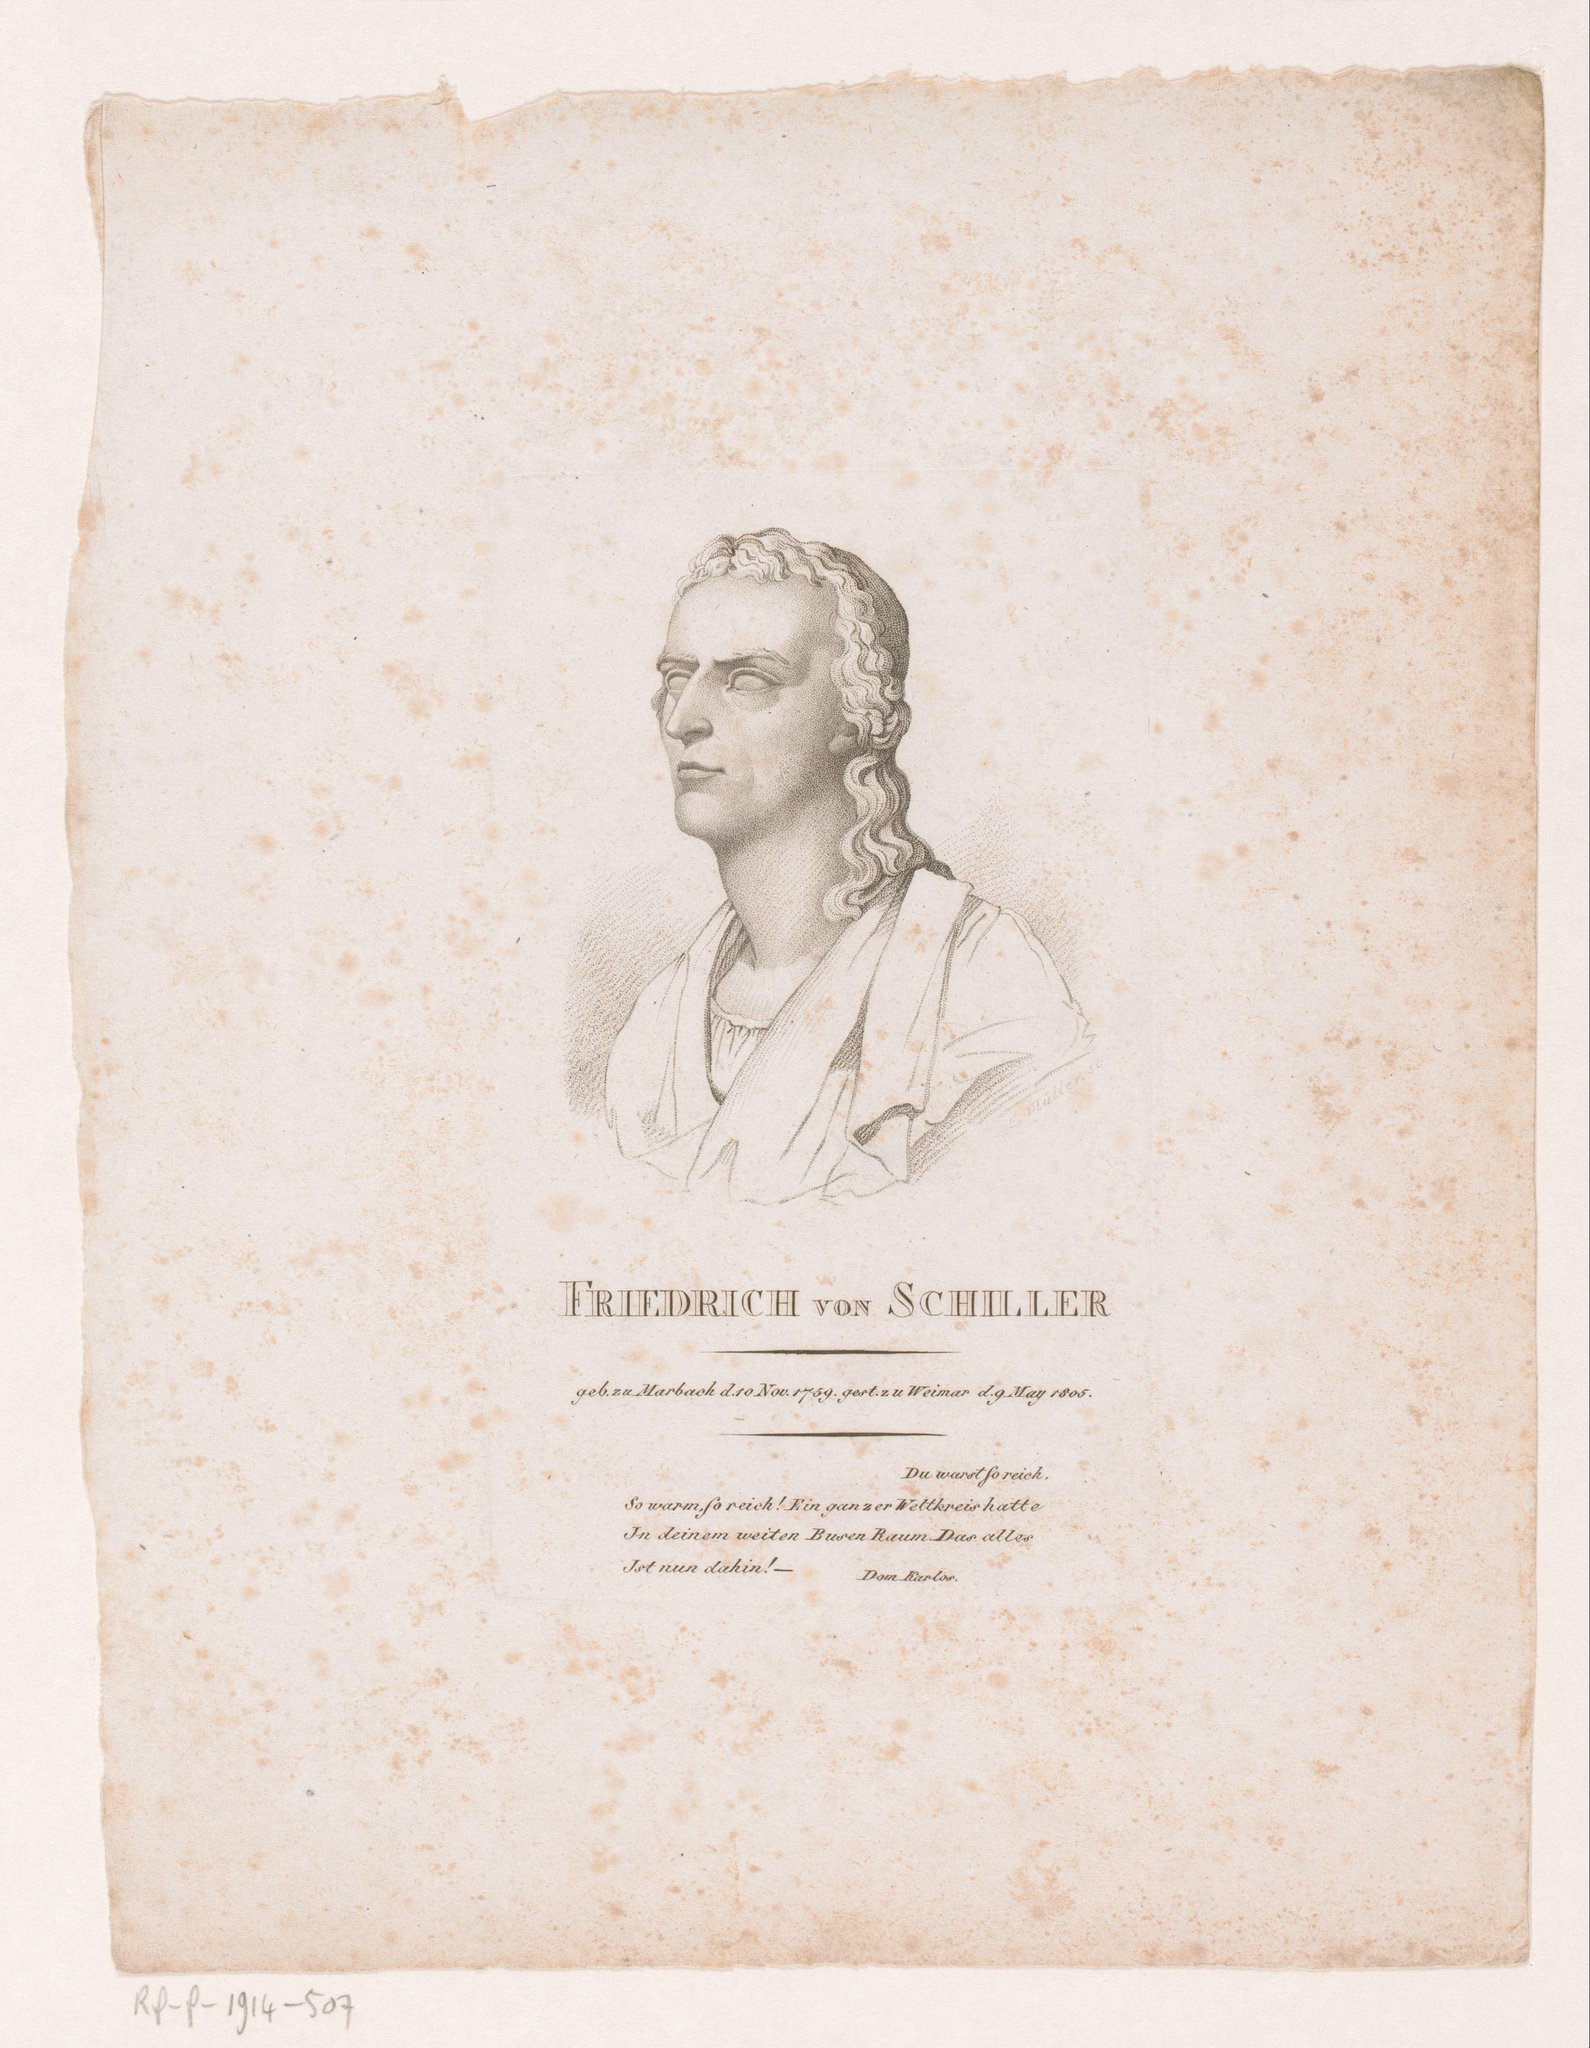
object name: print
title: Portret van Friedrich von Schiller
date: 1805-1824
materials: paper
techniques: engraving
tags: friedrich von schiller, writer, poet, author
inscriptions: collector's mark: Lugt 2228